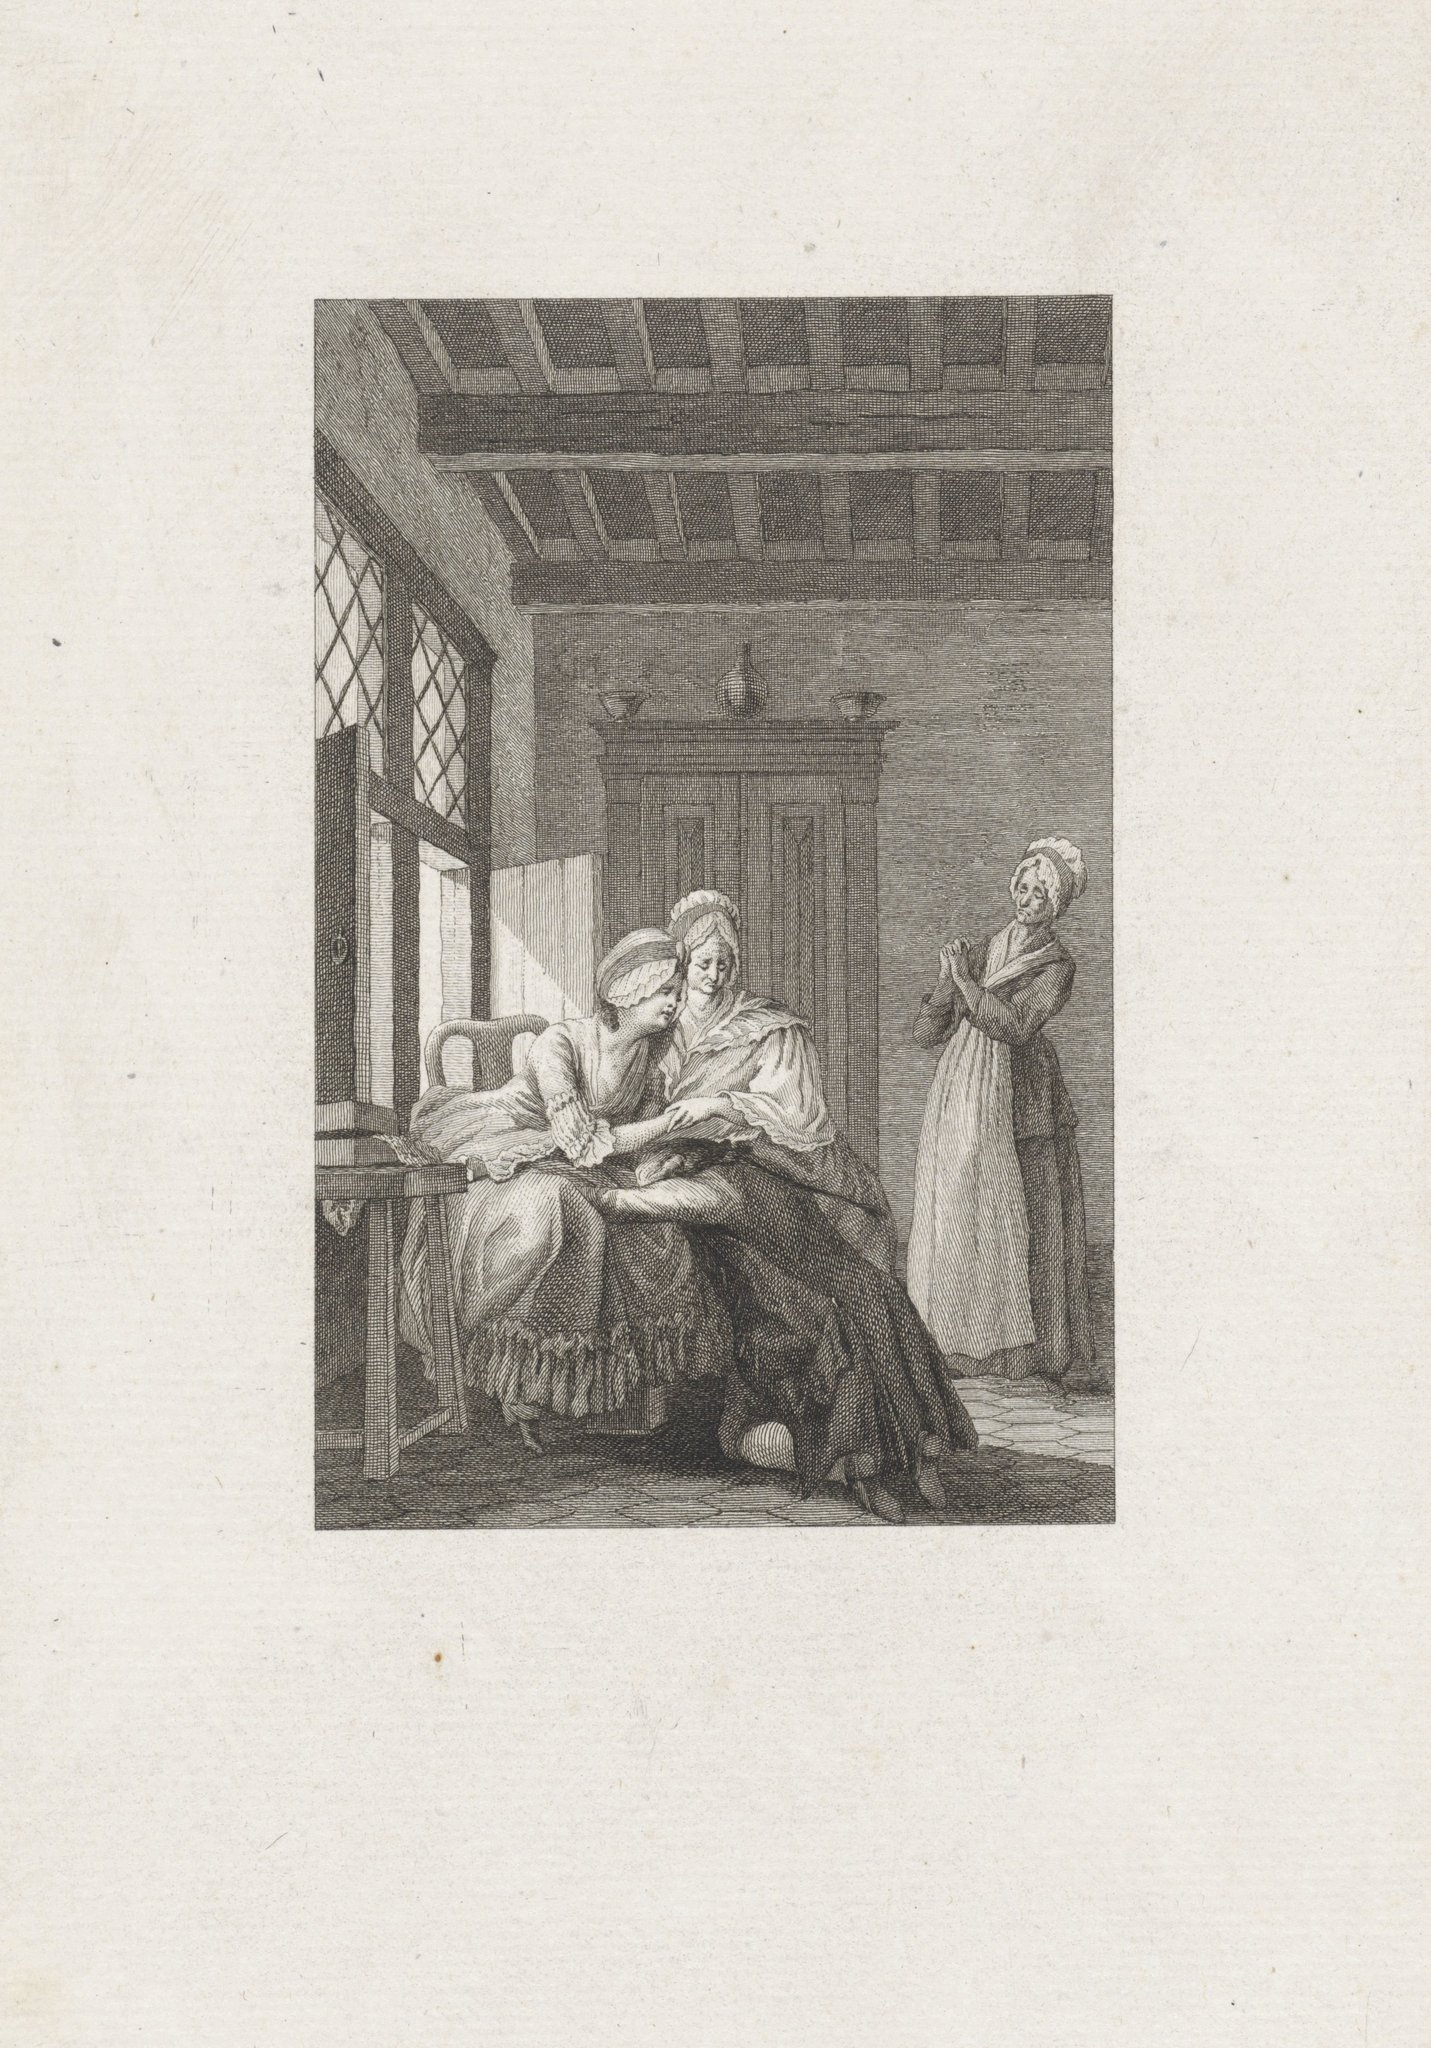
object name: print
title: Man huilt uit bij twee vrouwen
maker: reinier vinkeles (i)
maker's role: draughtsman, print maker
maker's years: 1741-1816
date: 1779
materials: paper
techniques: engraving, etching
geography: amsterdam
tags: comforter (weaning), weeping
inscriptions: collector's mark: Lugt 2228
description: Proefdruk van illustratie bij het verhaal Sidney en Volsan uit: Baculard d'Arnaud, François Thomas Marie de. Zedelyke verhaalen. Amsterdam: Anthony Mens Jansz. en A.E. Munnikhuisen, 1779.